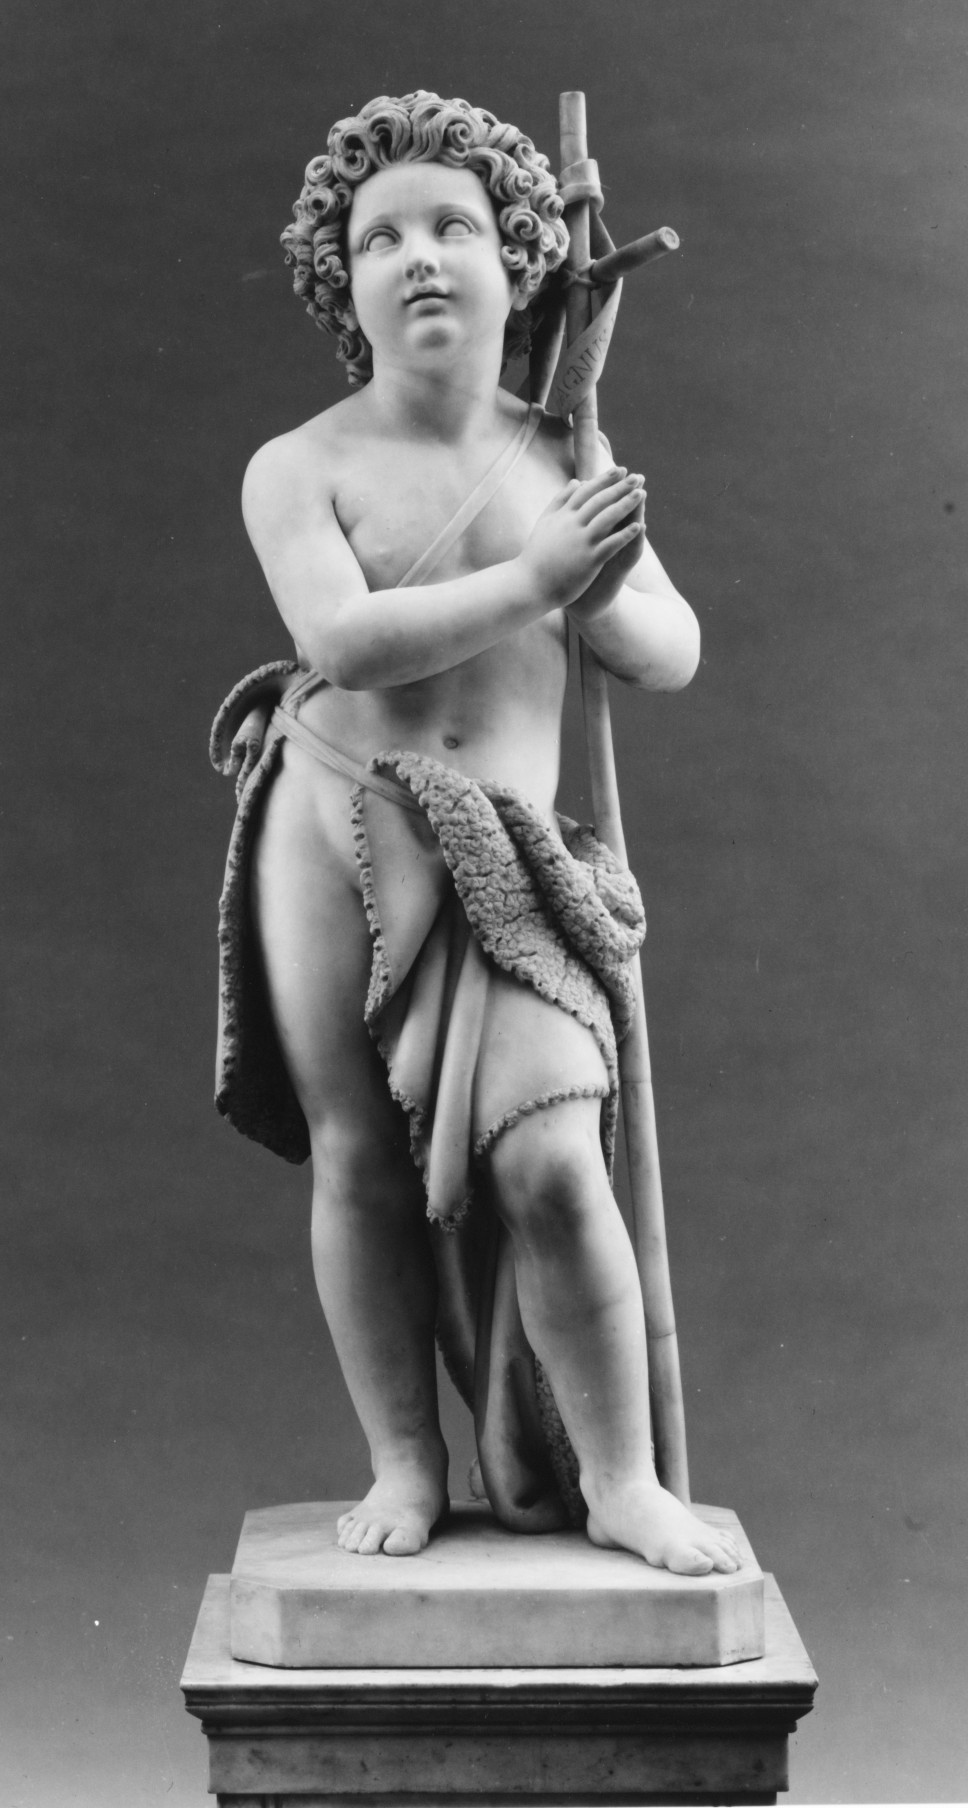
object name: statue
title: The Young St. John the Baptist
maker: luigi bienaimé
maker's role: artist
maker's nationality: italian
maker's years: 1795-1878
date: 1836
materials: marble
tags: boys,saint john the baptist